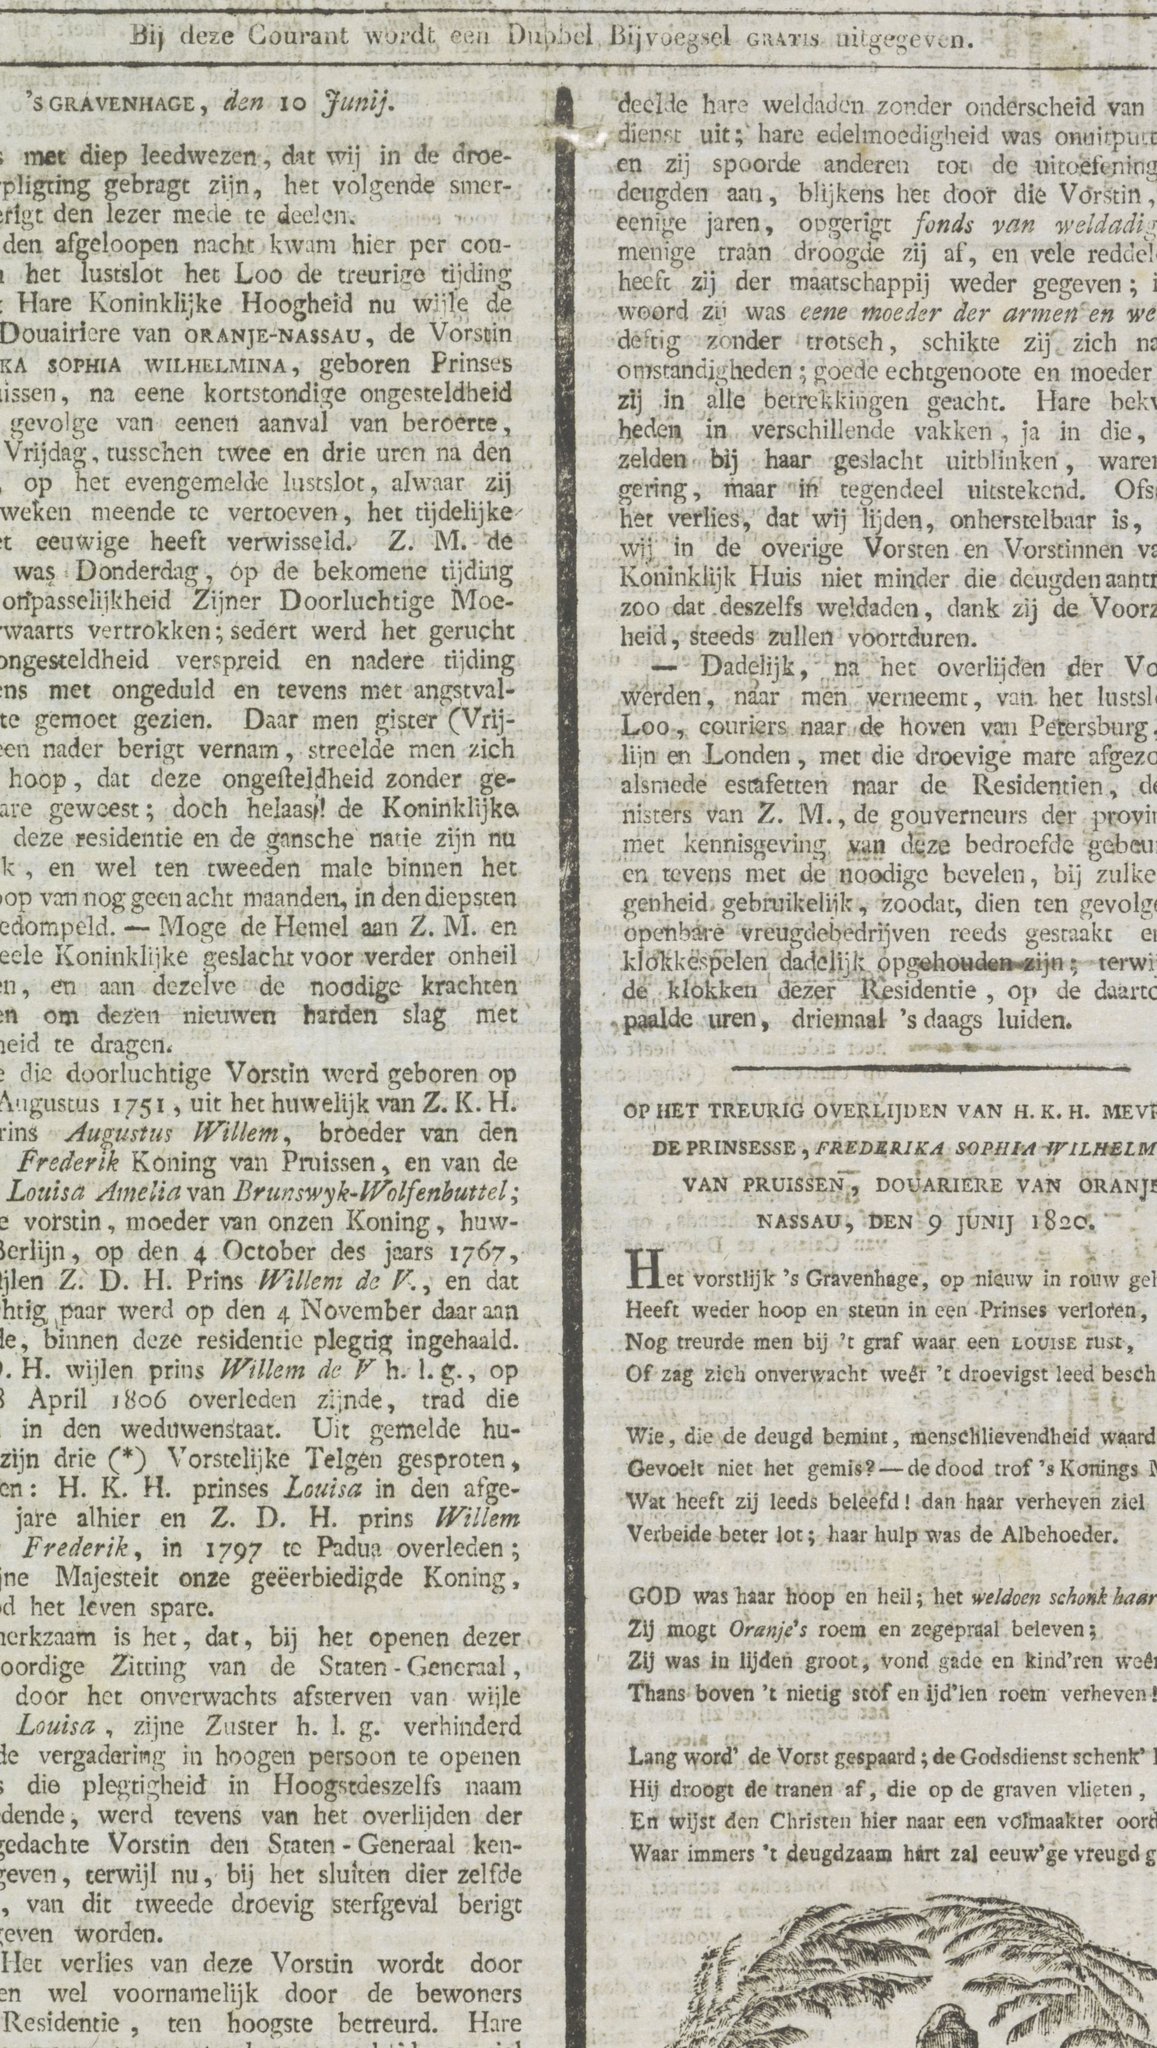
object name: newspaper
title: 'sGravenhaagsche Courant van 12 juni met het nieuws van het overlijden van Wilhelmina prinses-douairière van Oranje-Nassau, 1820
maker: Anonymous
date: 1820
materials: paper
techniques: letterpress printing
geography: the hague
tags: amsterdam, louise (prinses van oranje-nassau)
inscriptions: collector's mark: Lugt 2228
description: 'sGravenhaagsche Courant van 12 juni 1820 met het nieuws van het overlijden op 9 juni van Wilhelmina prinses-douairière van Oranje-Nassau, weduwe van prins Willem V. Blad met zwarte rouwranden en doodshoofden, bovenaan het stadswapen van Den Haag, onderaan een vignet met een putto treurend bij een grafsteen.